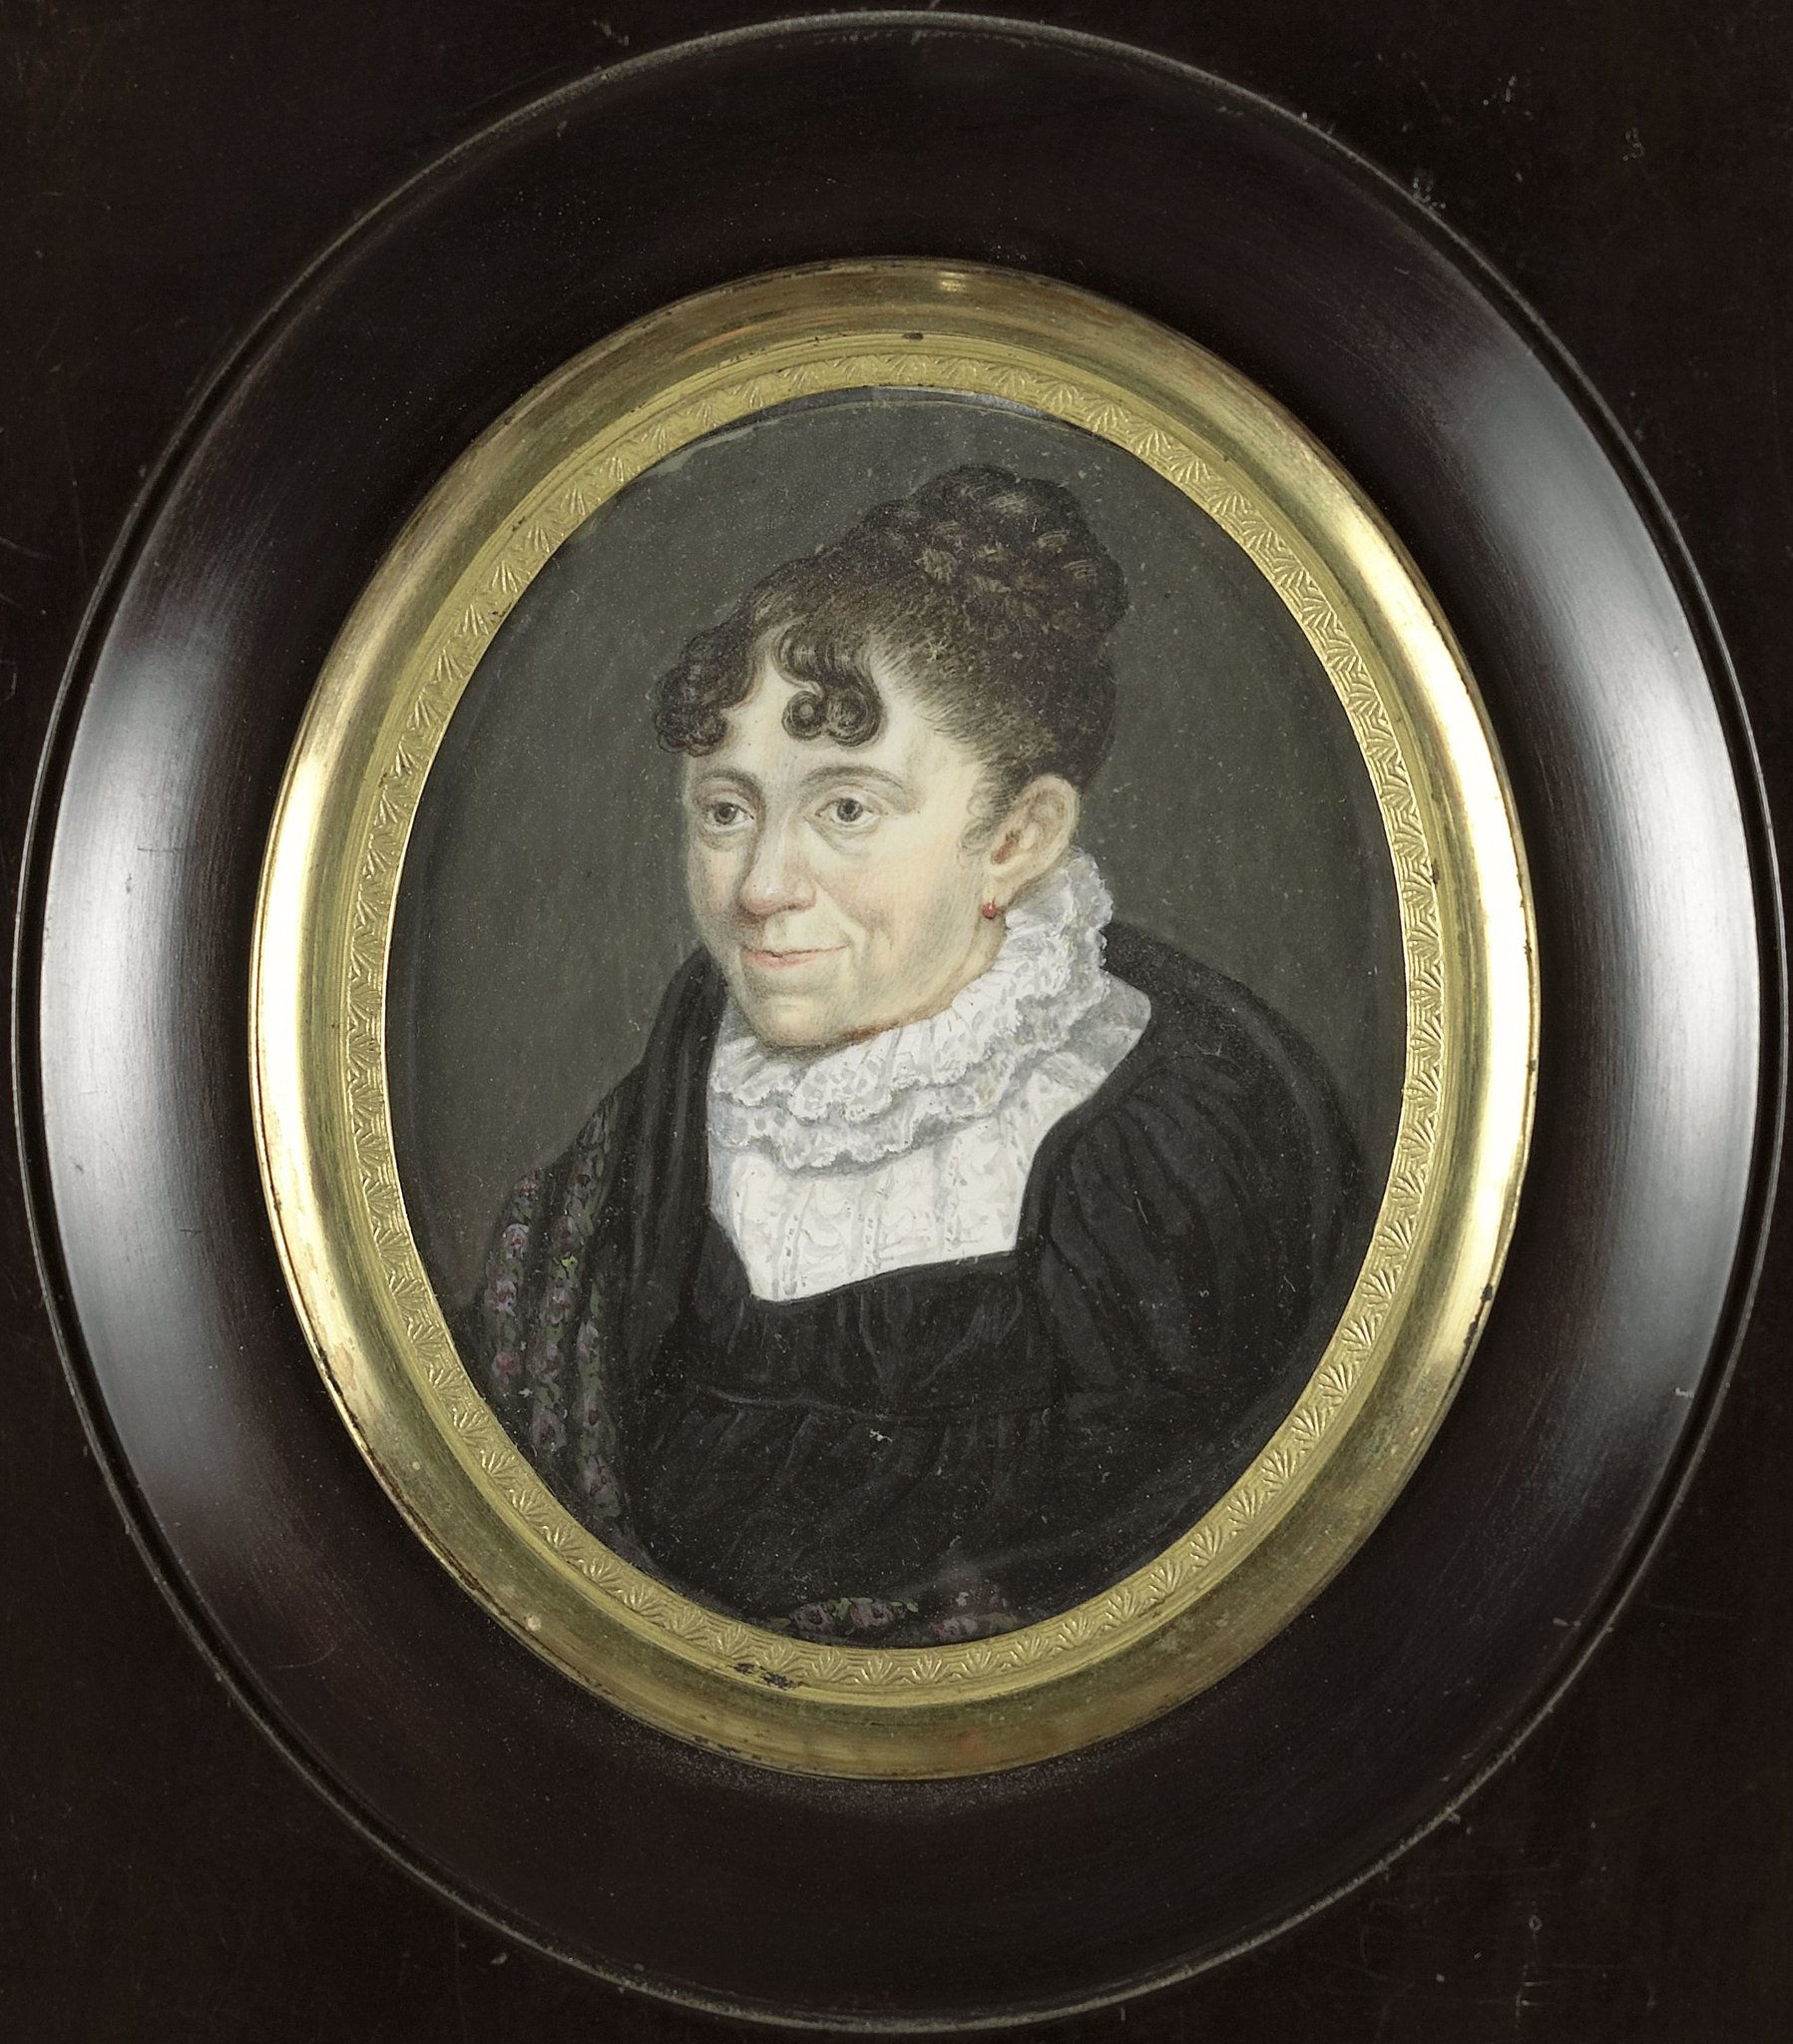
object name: painting, miniature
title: Portret van een oude dame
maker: Anonymous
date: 1810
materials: glass, ivory, metal, wood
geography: northern netherlands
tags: historical persons not known by name - bb - woman (+ profile portrait)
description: Portret van een oude dame. Buste, driekwart naar links. Onderdeel van de collectie portretminiaturen.